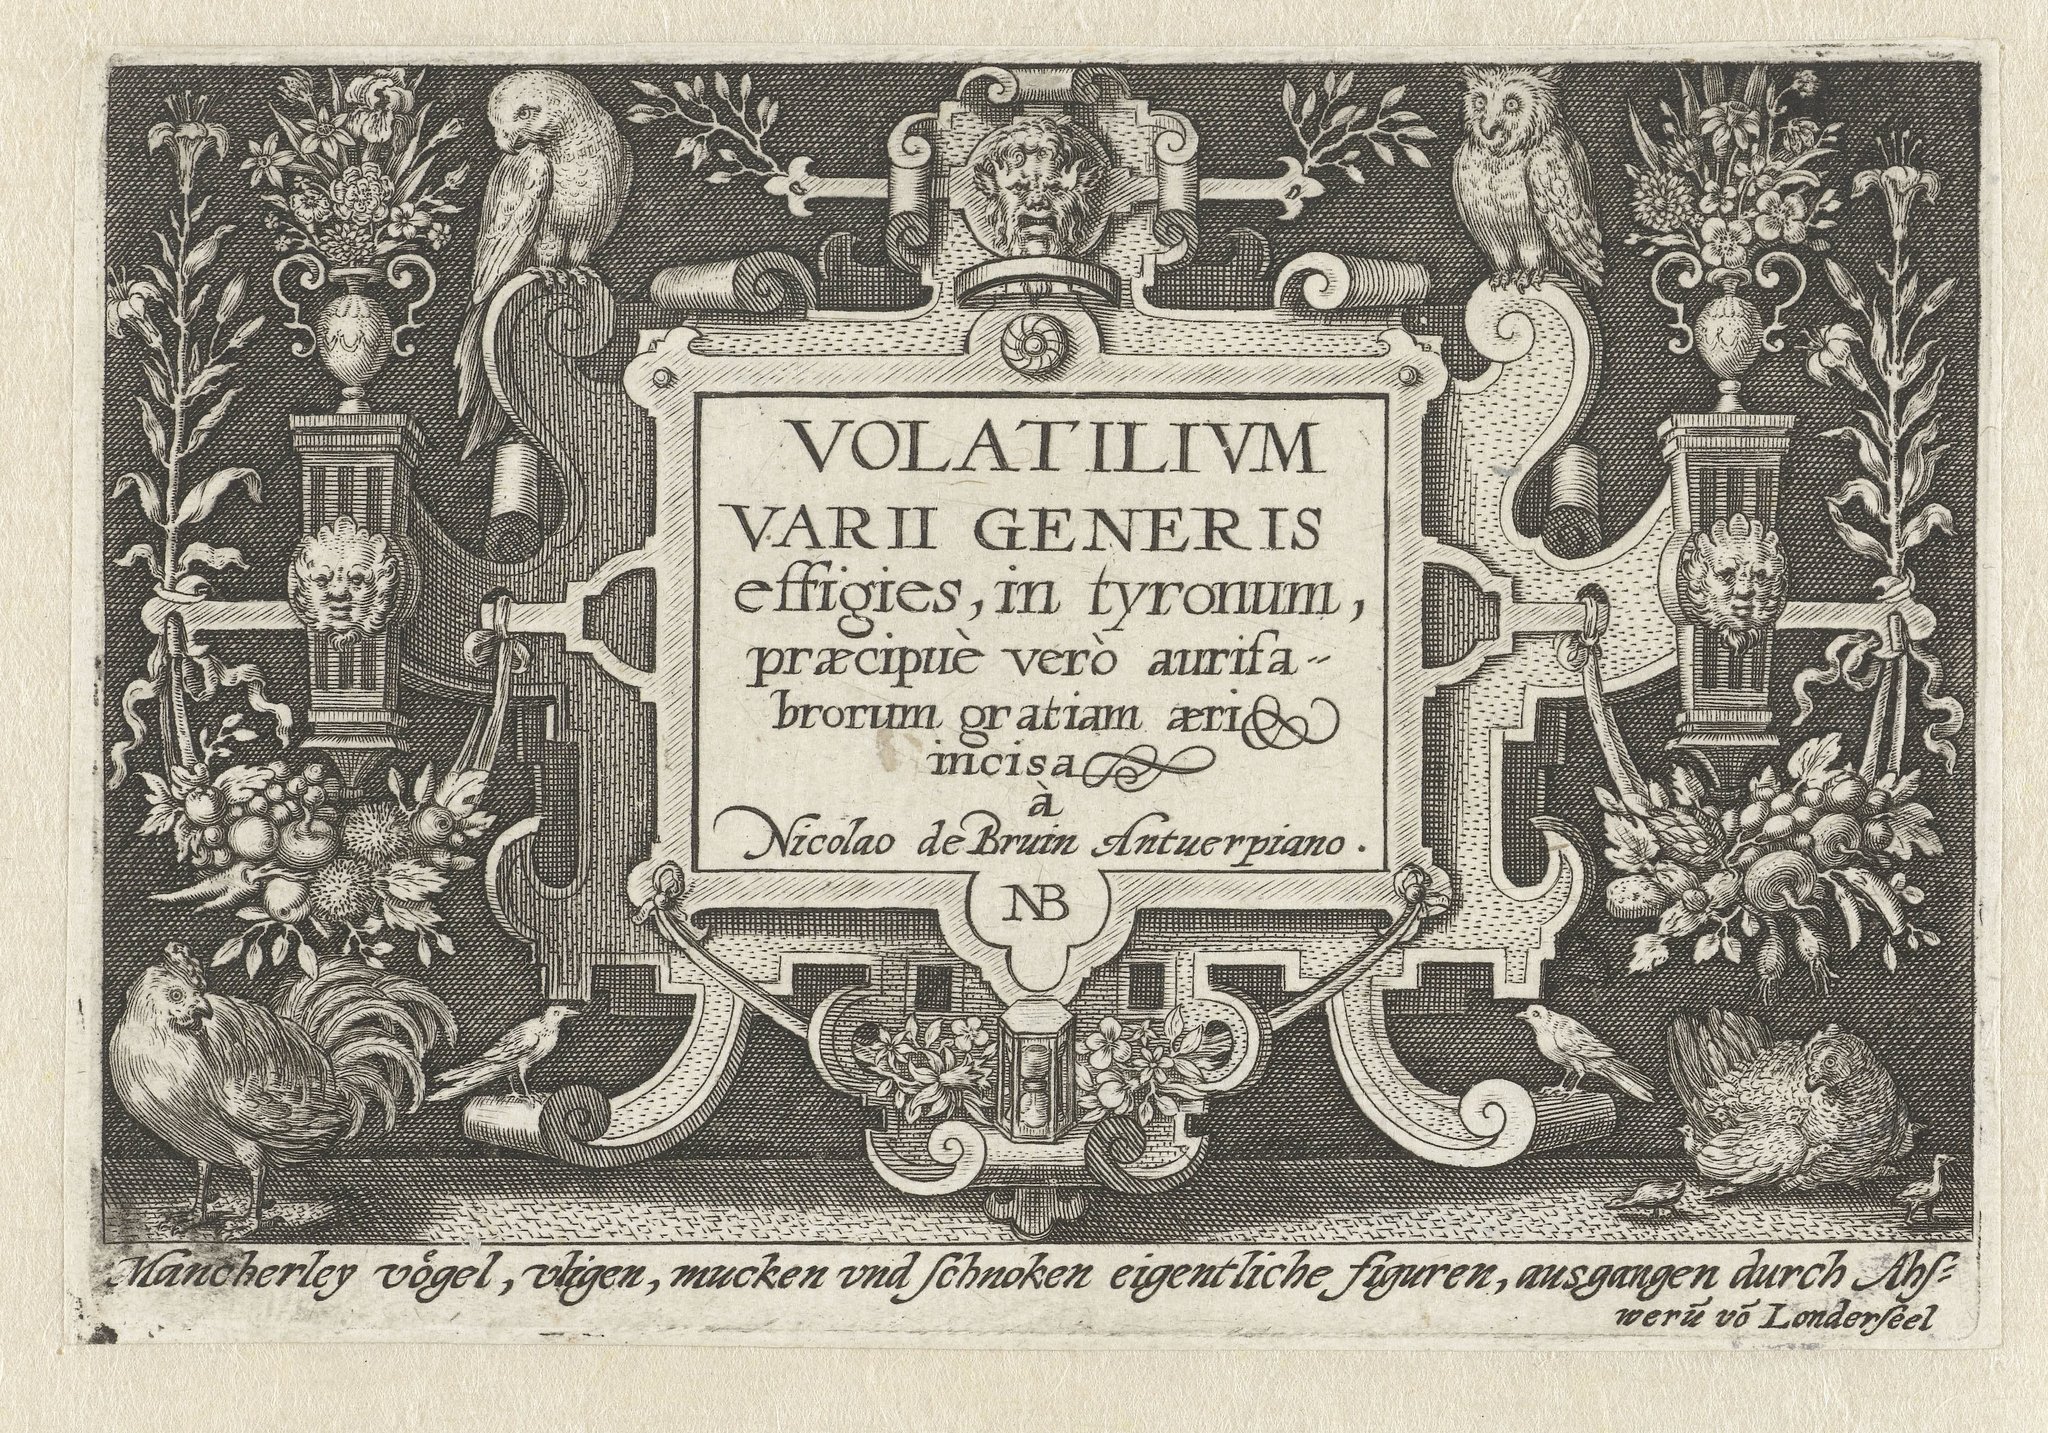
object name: print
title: Vogels en insecten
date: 1594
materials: paper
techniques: engraving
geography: antwerp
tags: birds, ornament ~ cartouche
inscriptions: collector's mark: Lugt 2228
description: Titelprent met titel in cartouche met ornamenten zoals guirlandes en bloemvazen. Vogels waaronder papegaai en uil zitten op het rolwerk. Onder een haan en hen met kuikens. In marge onder regel Duitse tekst.